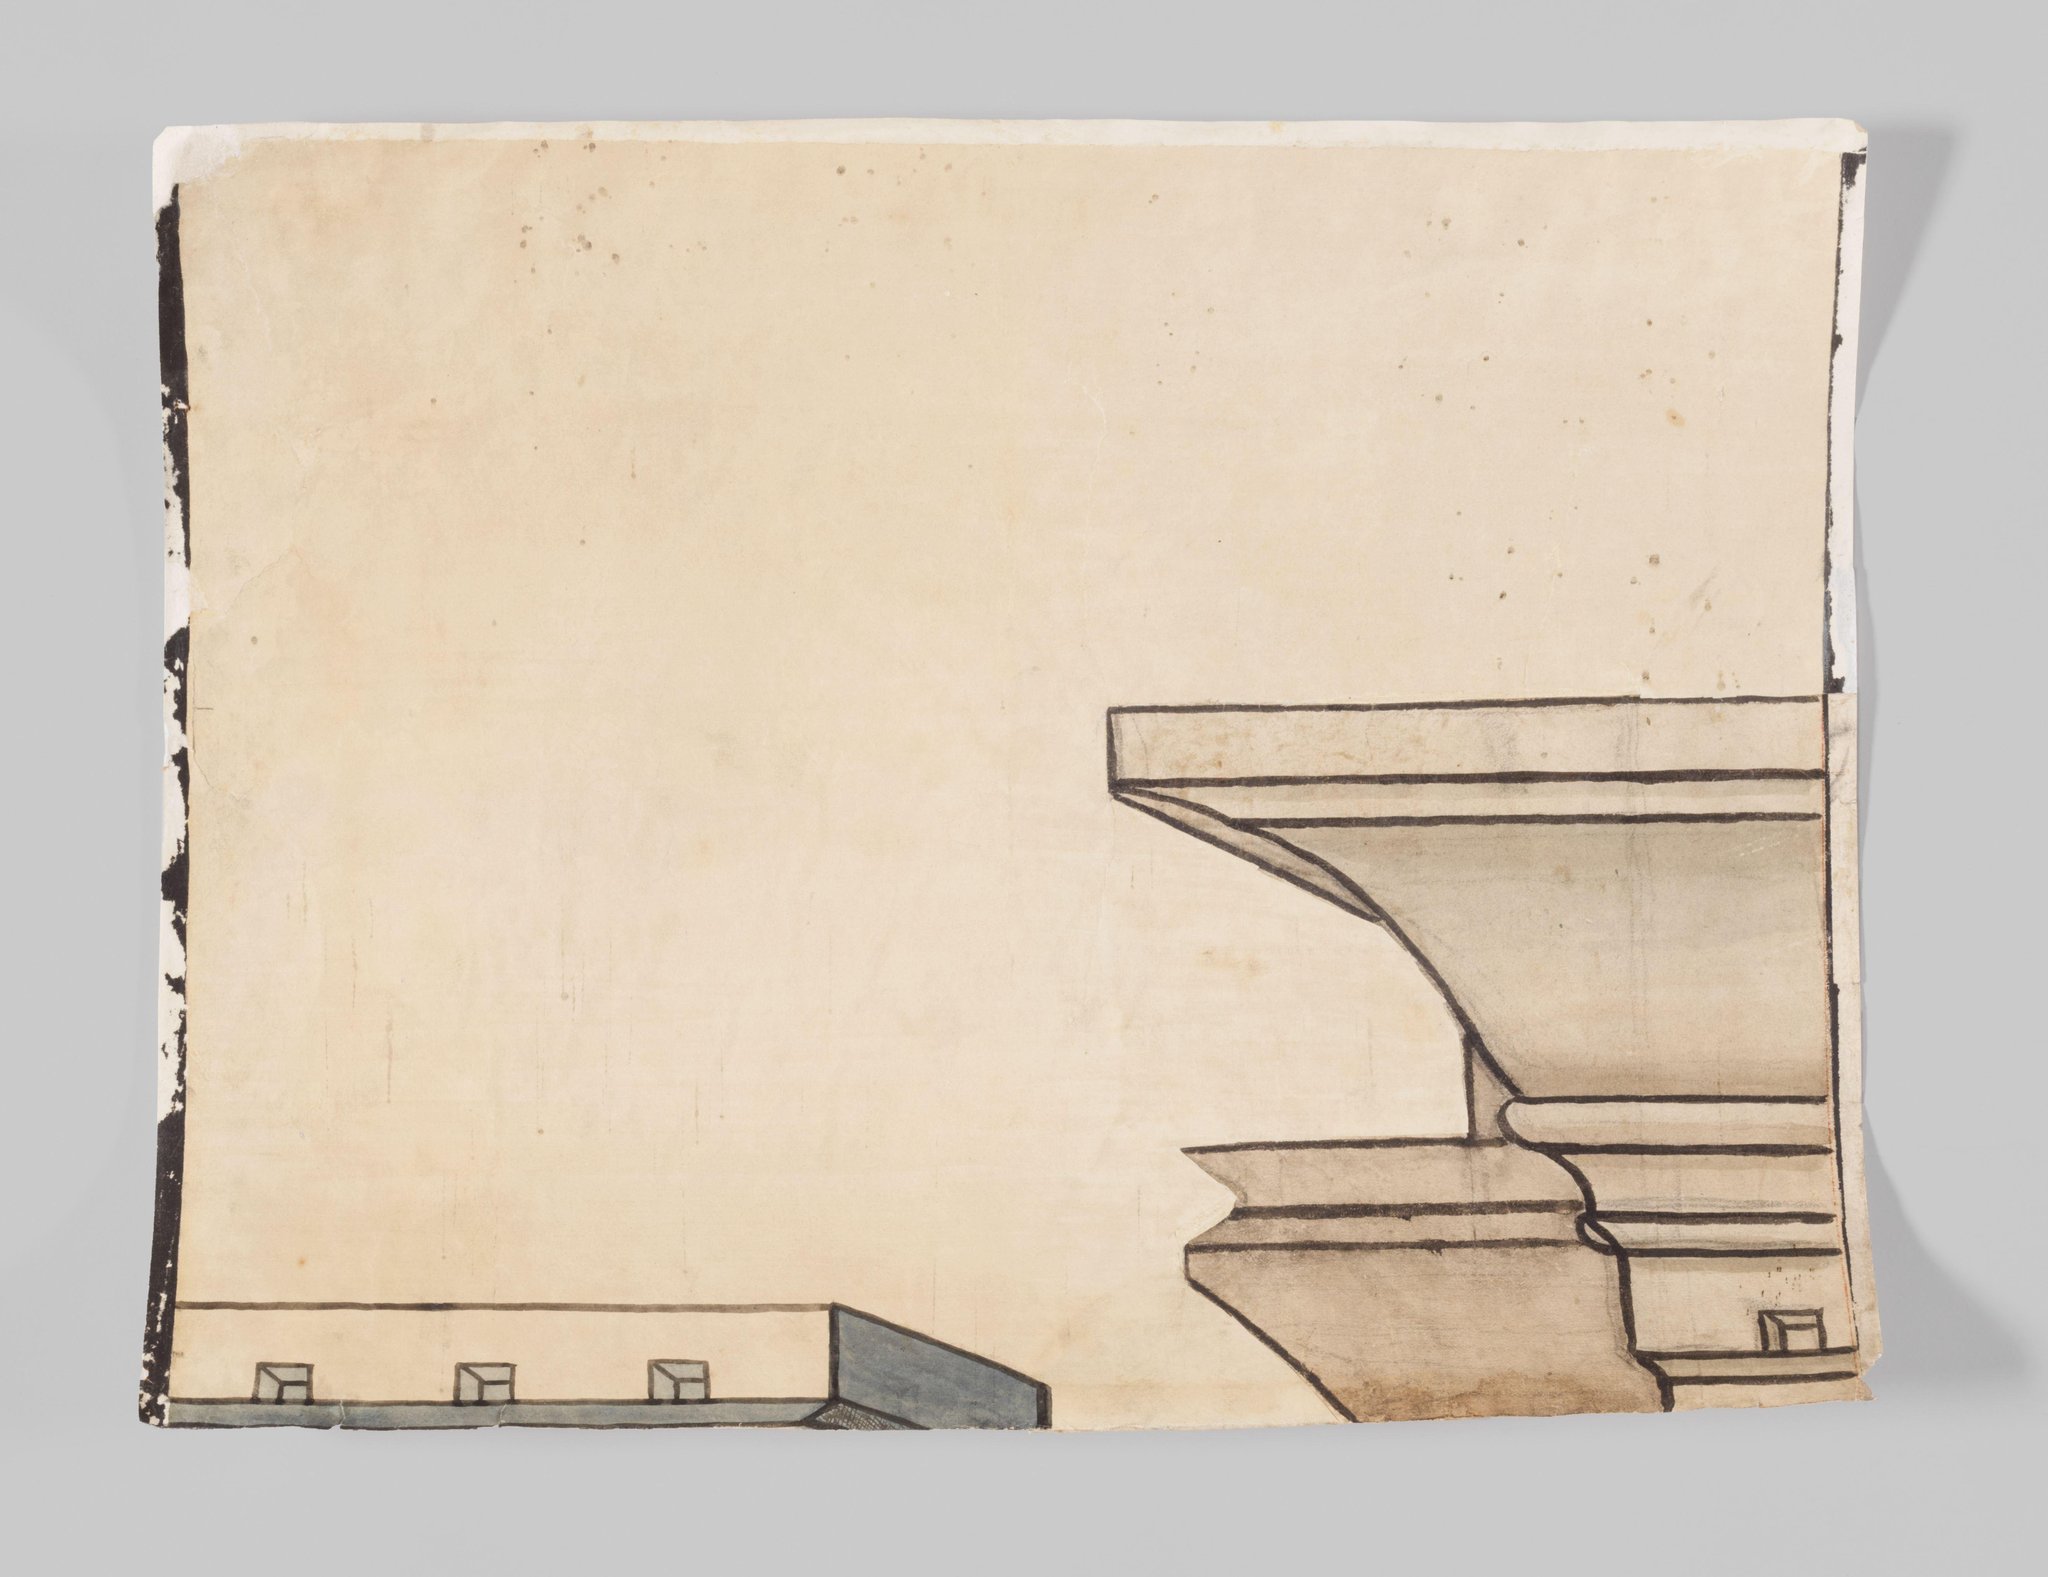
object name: drawing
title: Fragmenten karton voor het glasraam in de westgevel van Joris van Egmond (Bisschop van Utrecht 1535-1559) voor de Sint Bavo Kerk te Haarlem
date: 1541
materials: chalk, charcoal, paper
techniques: brush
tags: clergyman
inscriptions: date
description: Ontwerpen voor een glasraam. A-IV-3 - A-IV-13. Verpakt in kartonnen doos.